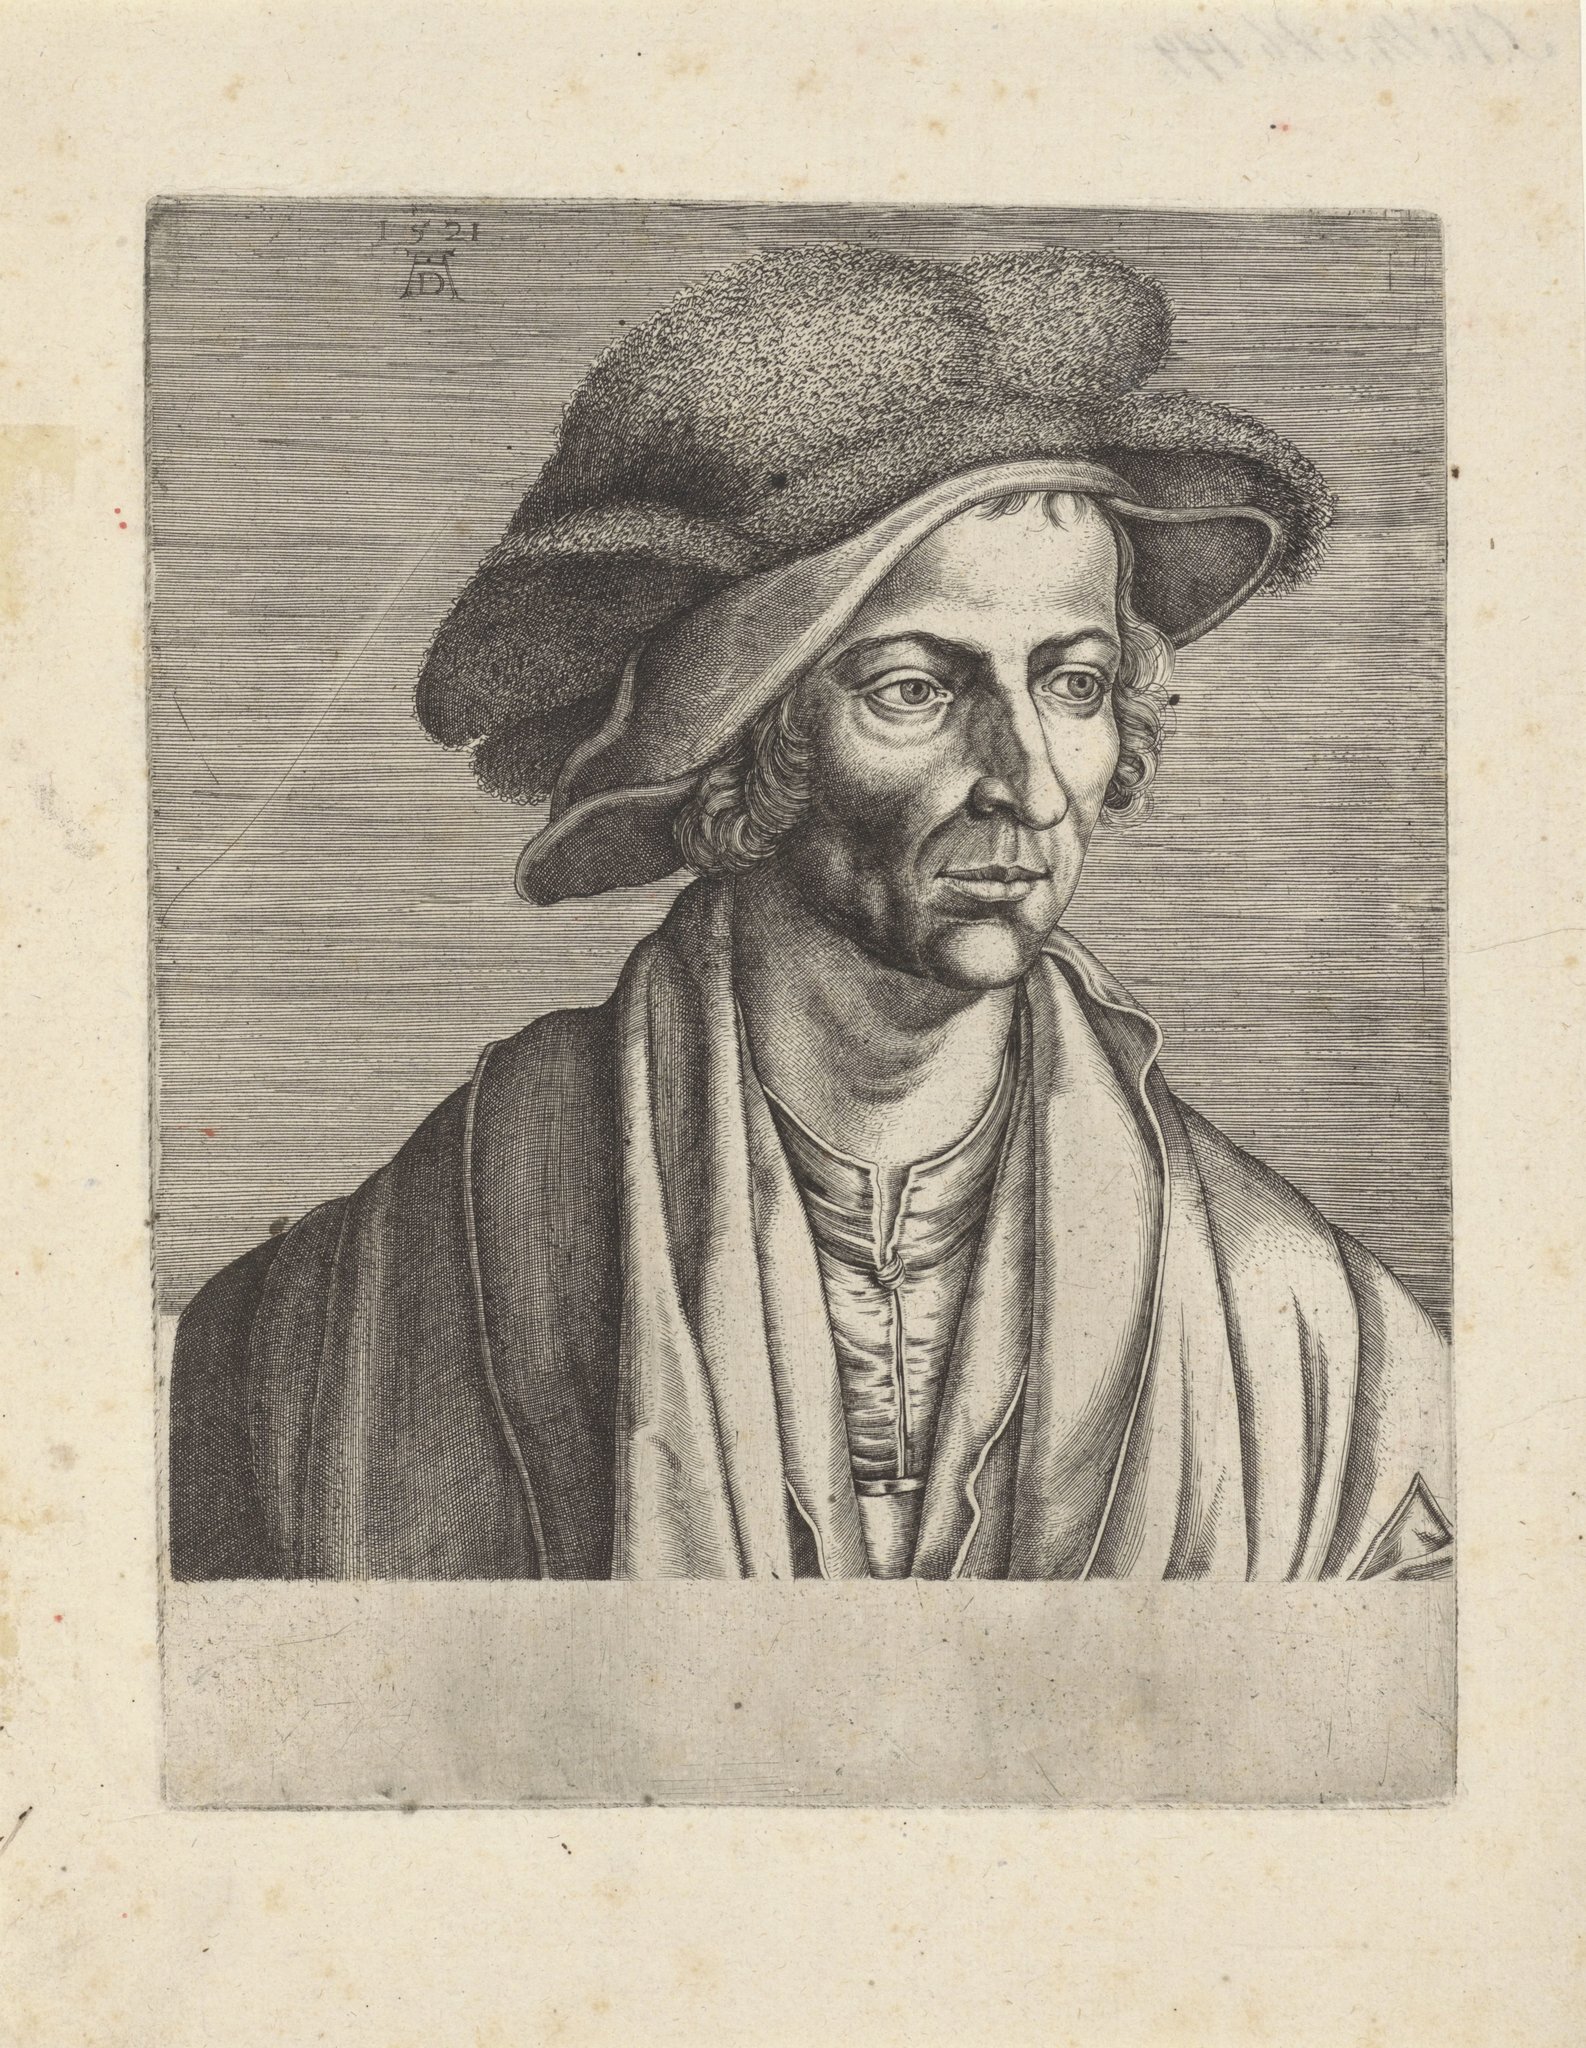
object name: print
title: Portret van Joachim Patinier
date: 1521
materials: paper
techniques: engraving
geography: prague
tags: antwerp, painter, draughtsman, joachim patinir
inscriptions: inscription: ‘S. W. Ab. 194’, collector's mark: Lugt 2760, collector's mark: Lugt 2228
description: Portret van de schilder Joachim Patinier.